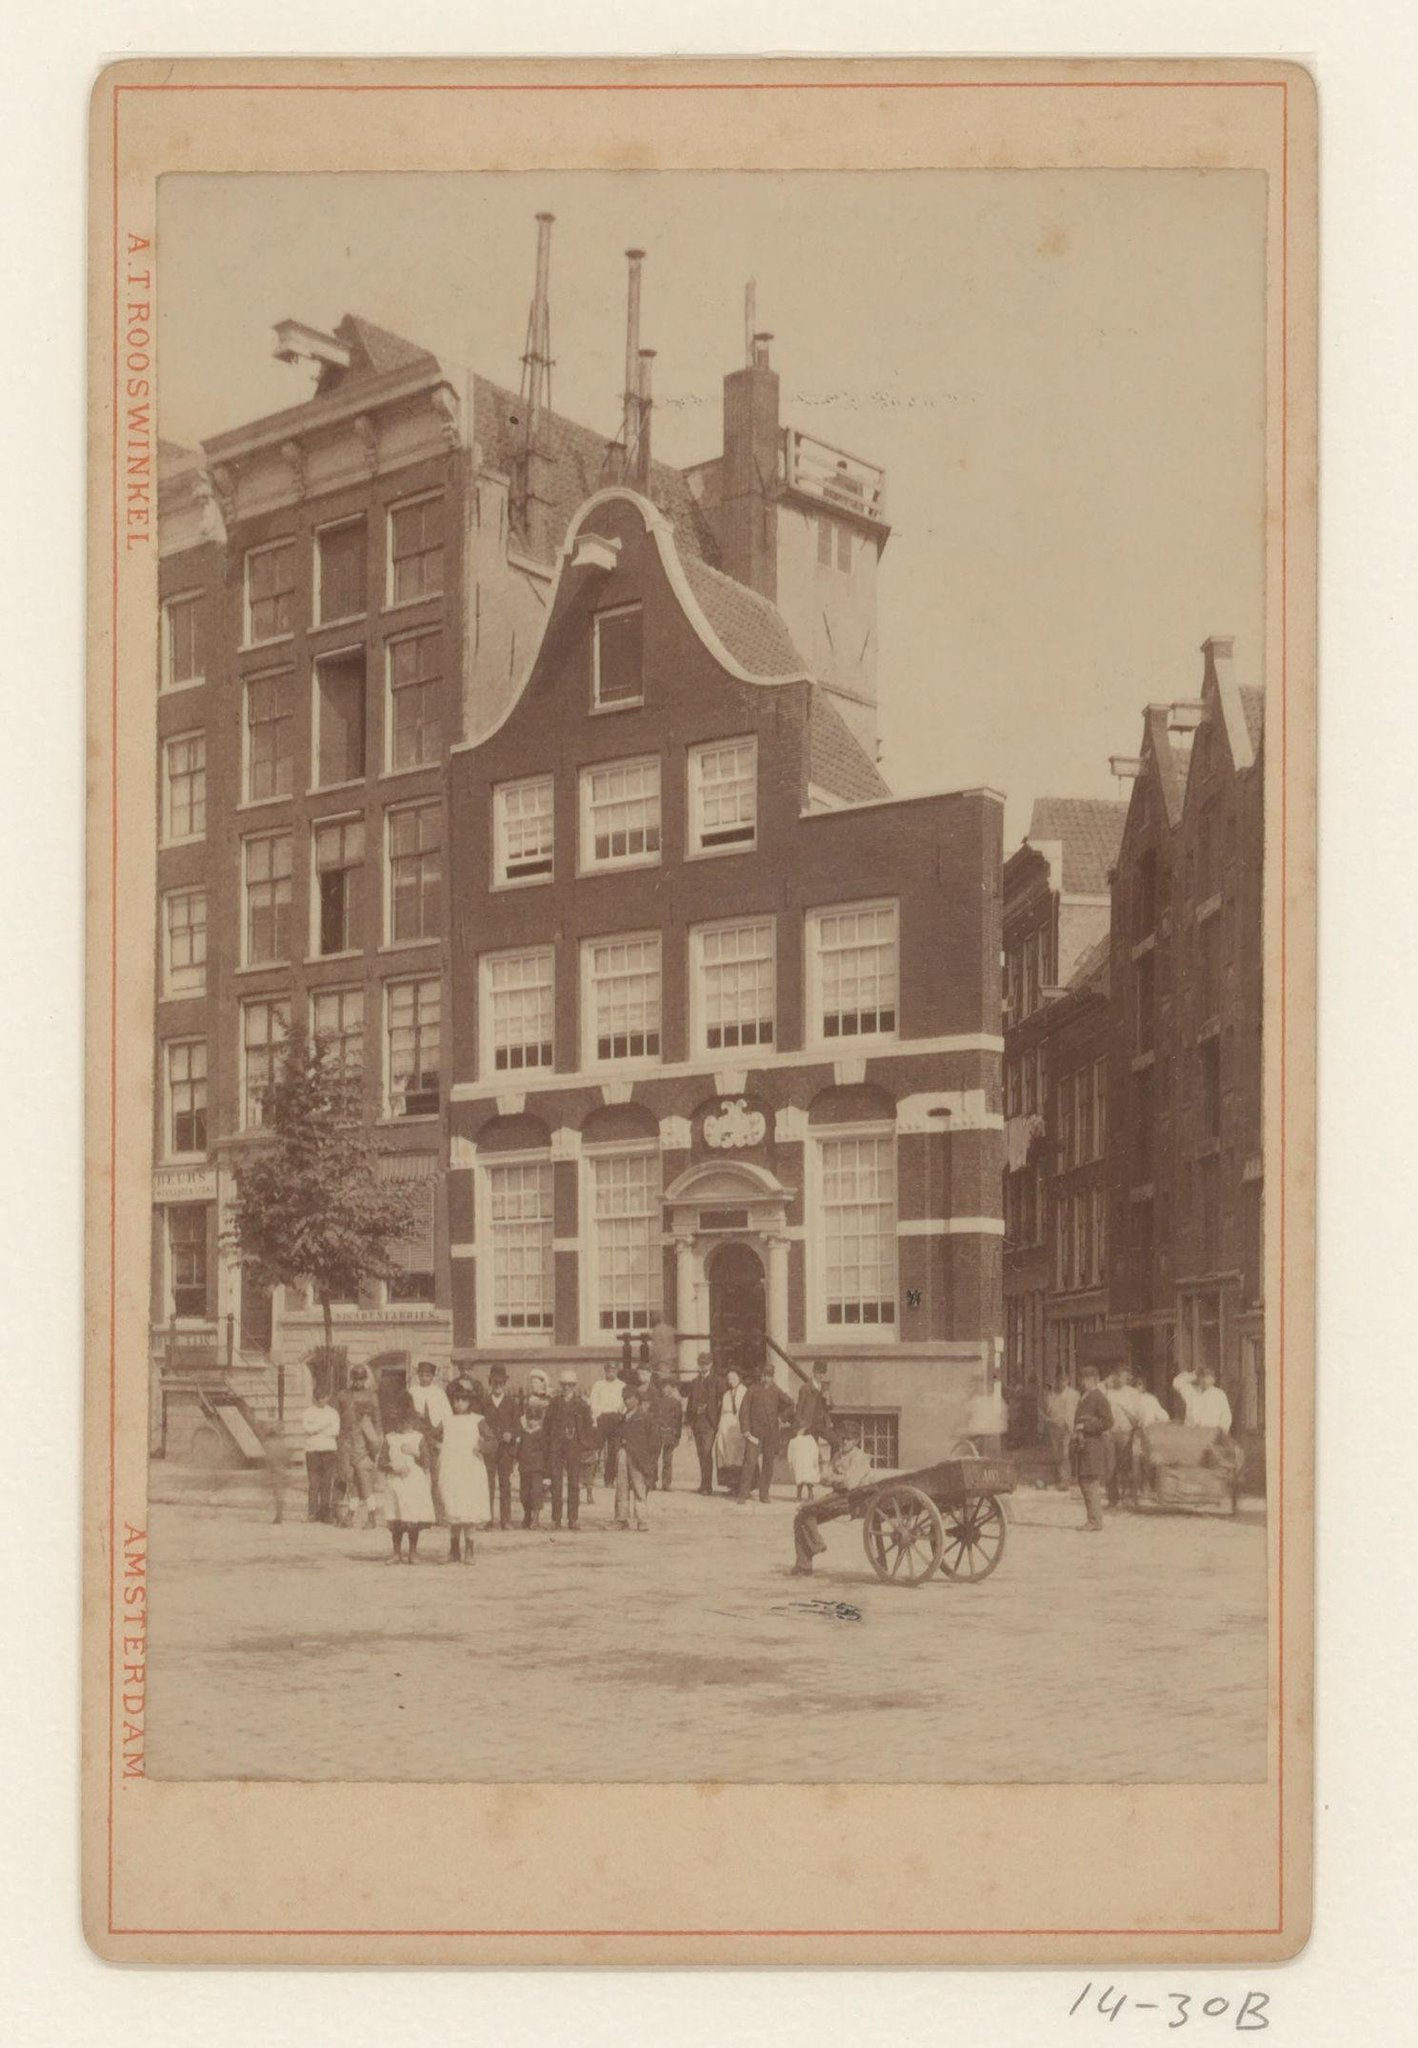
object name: cabinet photograph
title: Gezicht op de Nieuwezijds Voorburgwal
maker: andreas theodorus rooswinkel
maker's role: fotograaf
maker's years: 1838-1909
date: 1884-1909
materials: cardboard, paper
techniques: albumen print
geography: amsterdam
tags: city-view in general; 'veduta', the usual house or row of houses, street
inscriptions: inscription: ‘49 Nieuwe Zijdsvoorburgwal’, collector's mark: ‘14.30B’ Lugt 1641b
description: Onderwerpsrubriek binnen de Atlas Amsterdam: Verhulststraat (Johannes), Viaducten, Vierwindenstraat, Vinkenbuurt, Vinkenpad, Vinkenstraat, Vischsteeg, Vliegendesteeg, Voetboogstraat, Volewijk, Vondelstraat, Voorburgwal (N.Z.).